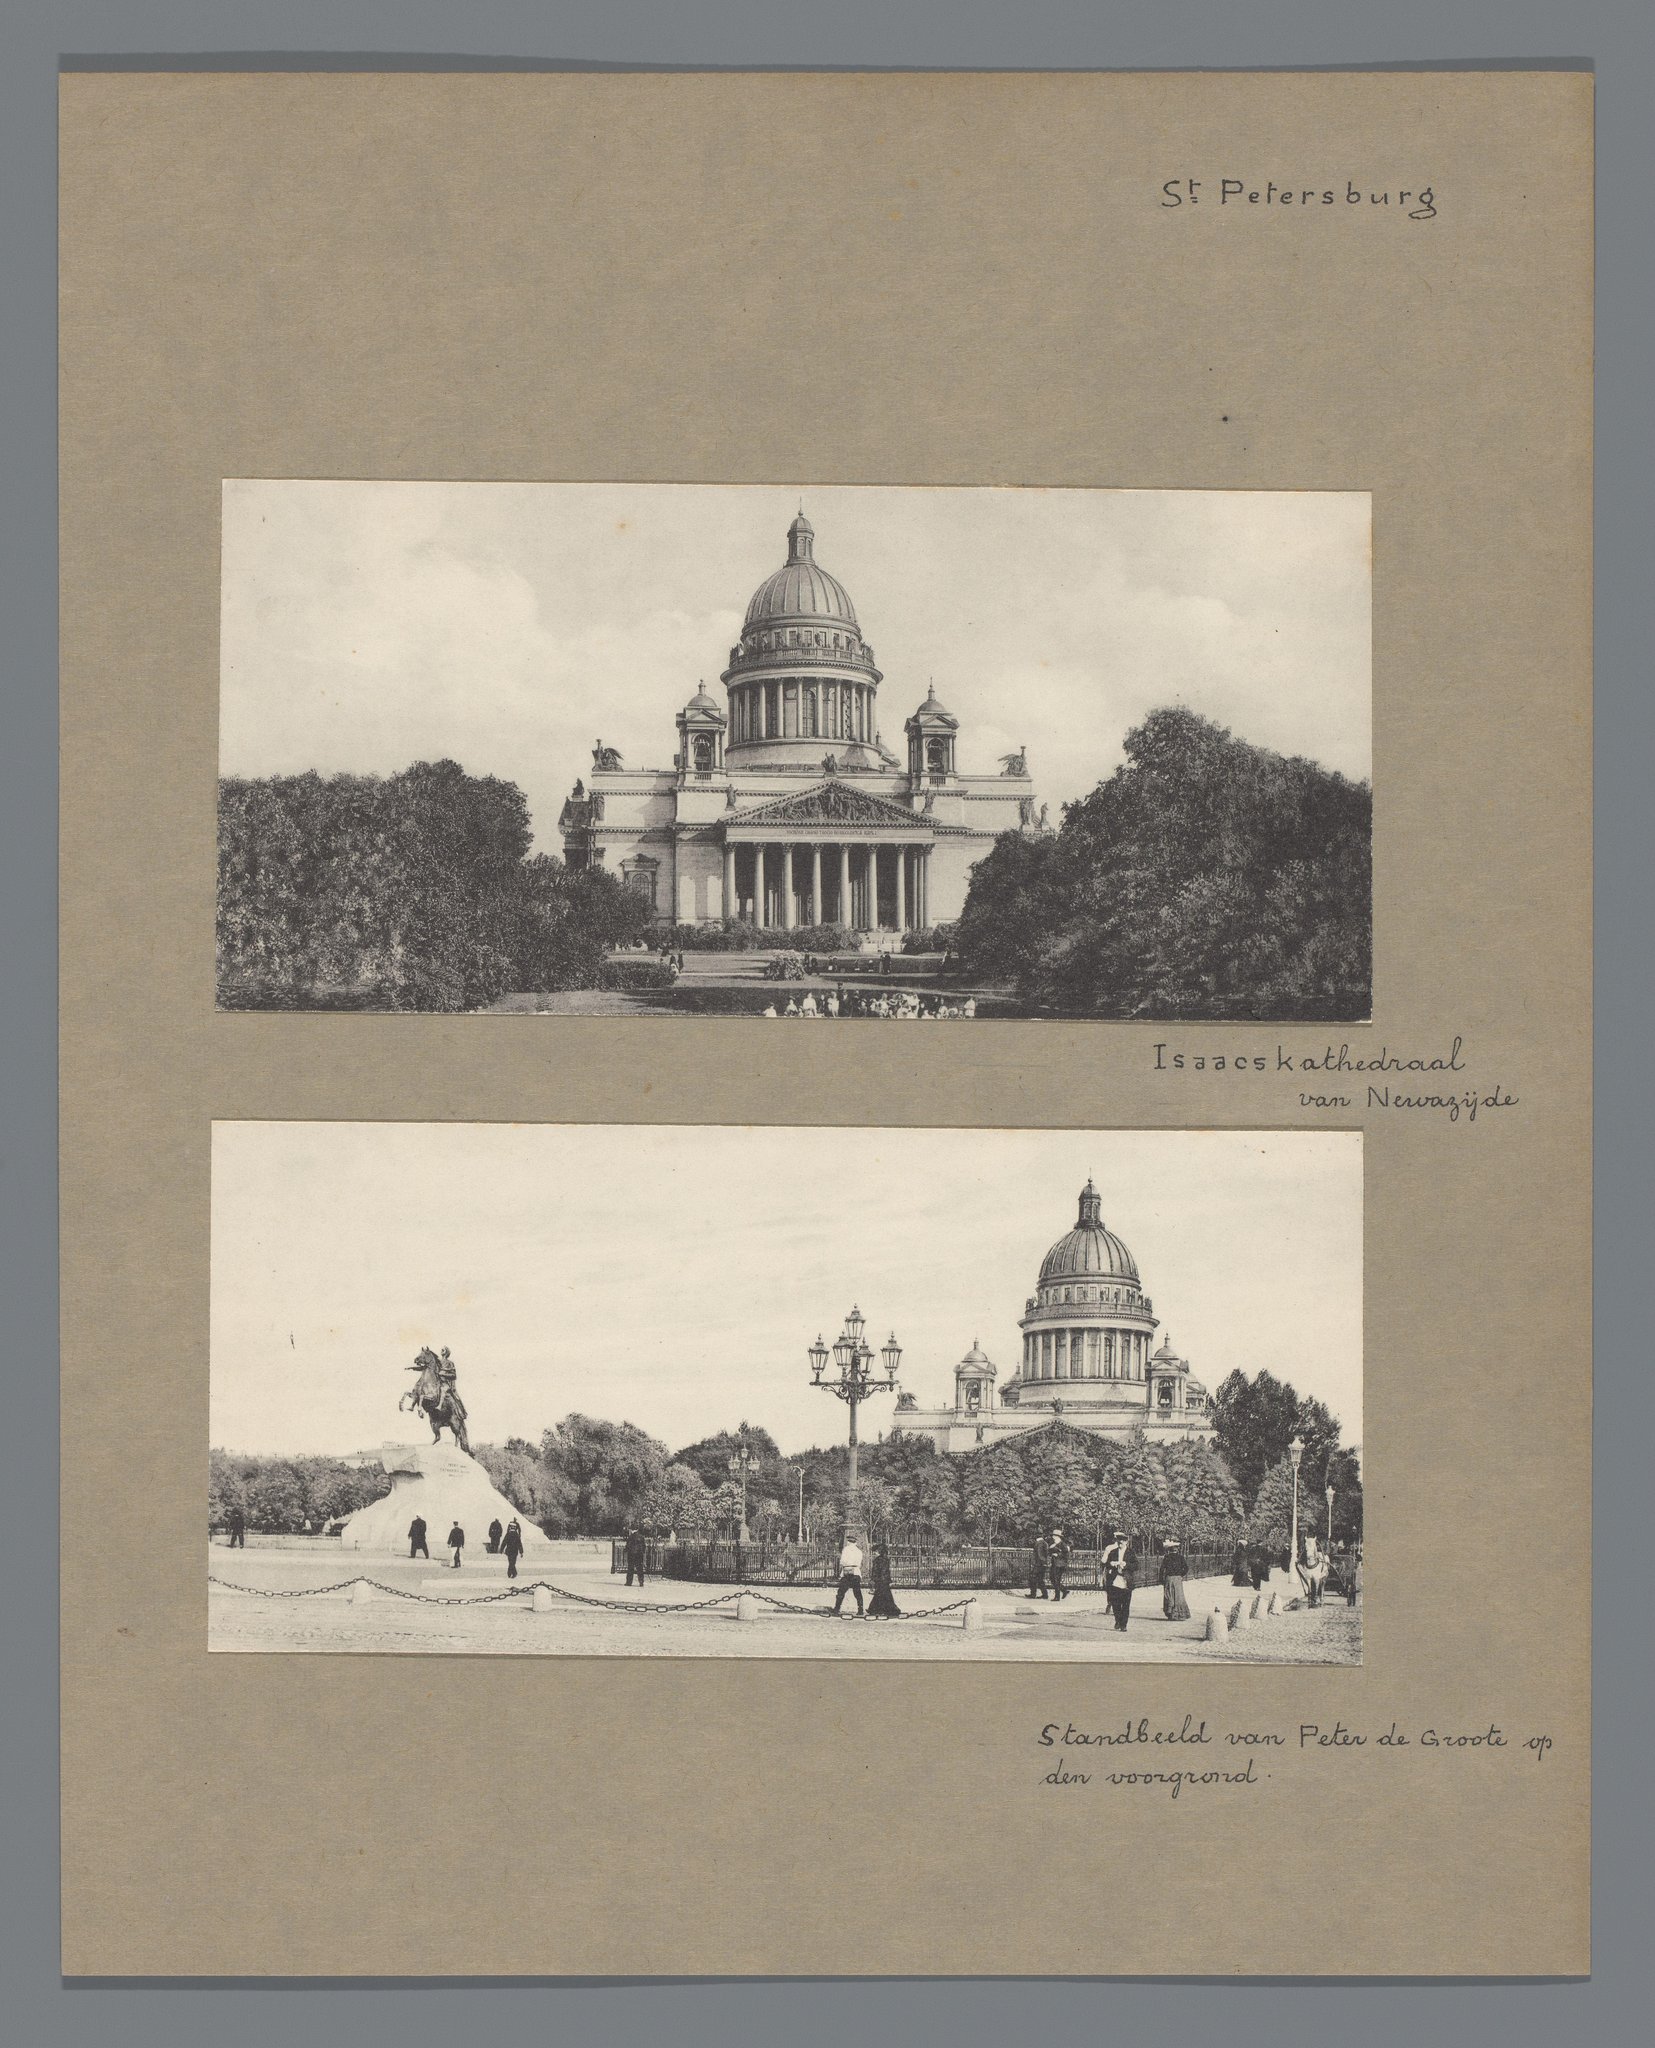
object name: photograph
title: St. Petersburg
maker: Anonymous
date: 1860-1925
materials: photographic support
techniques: photograph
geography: russia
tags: sint-petersburg